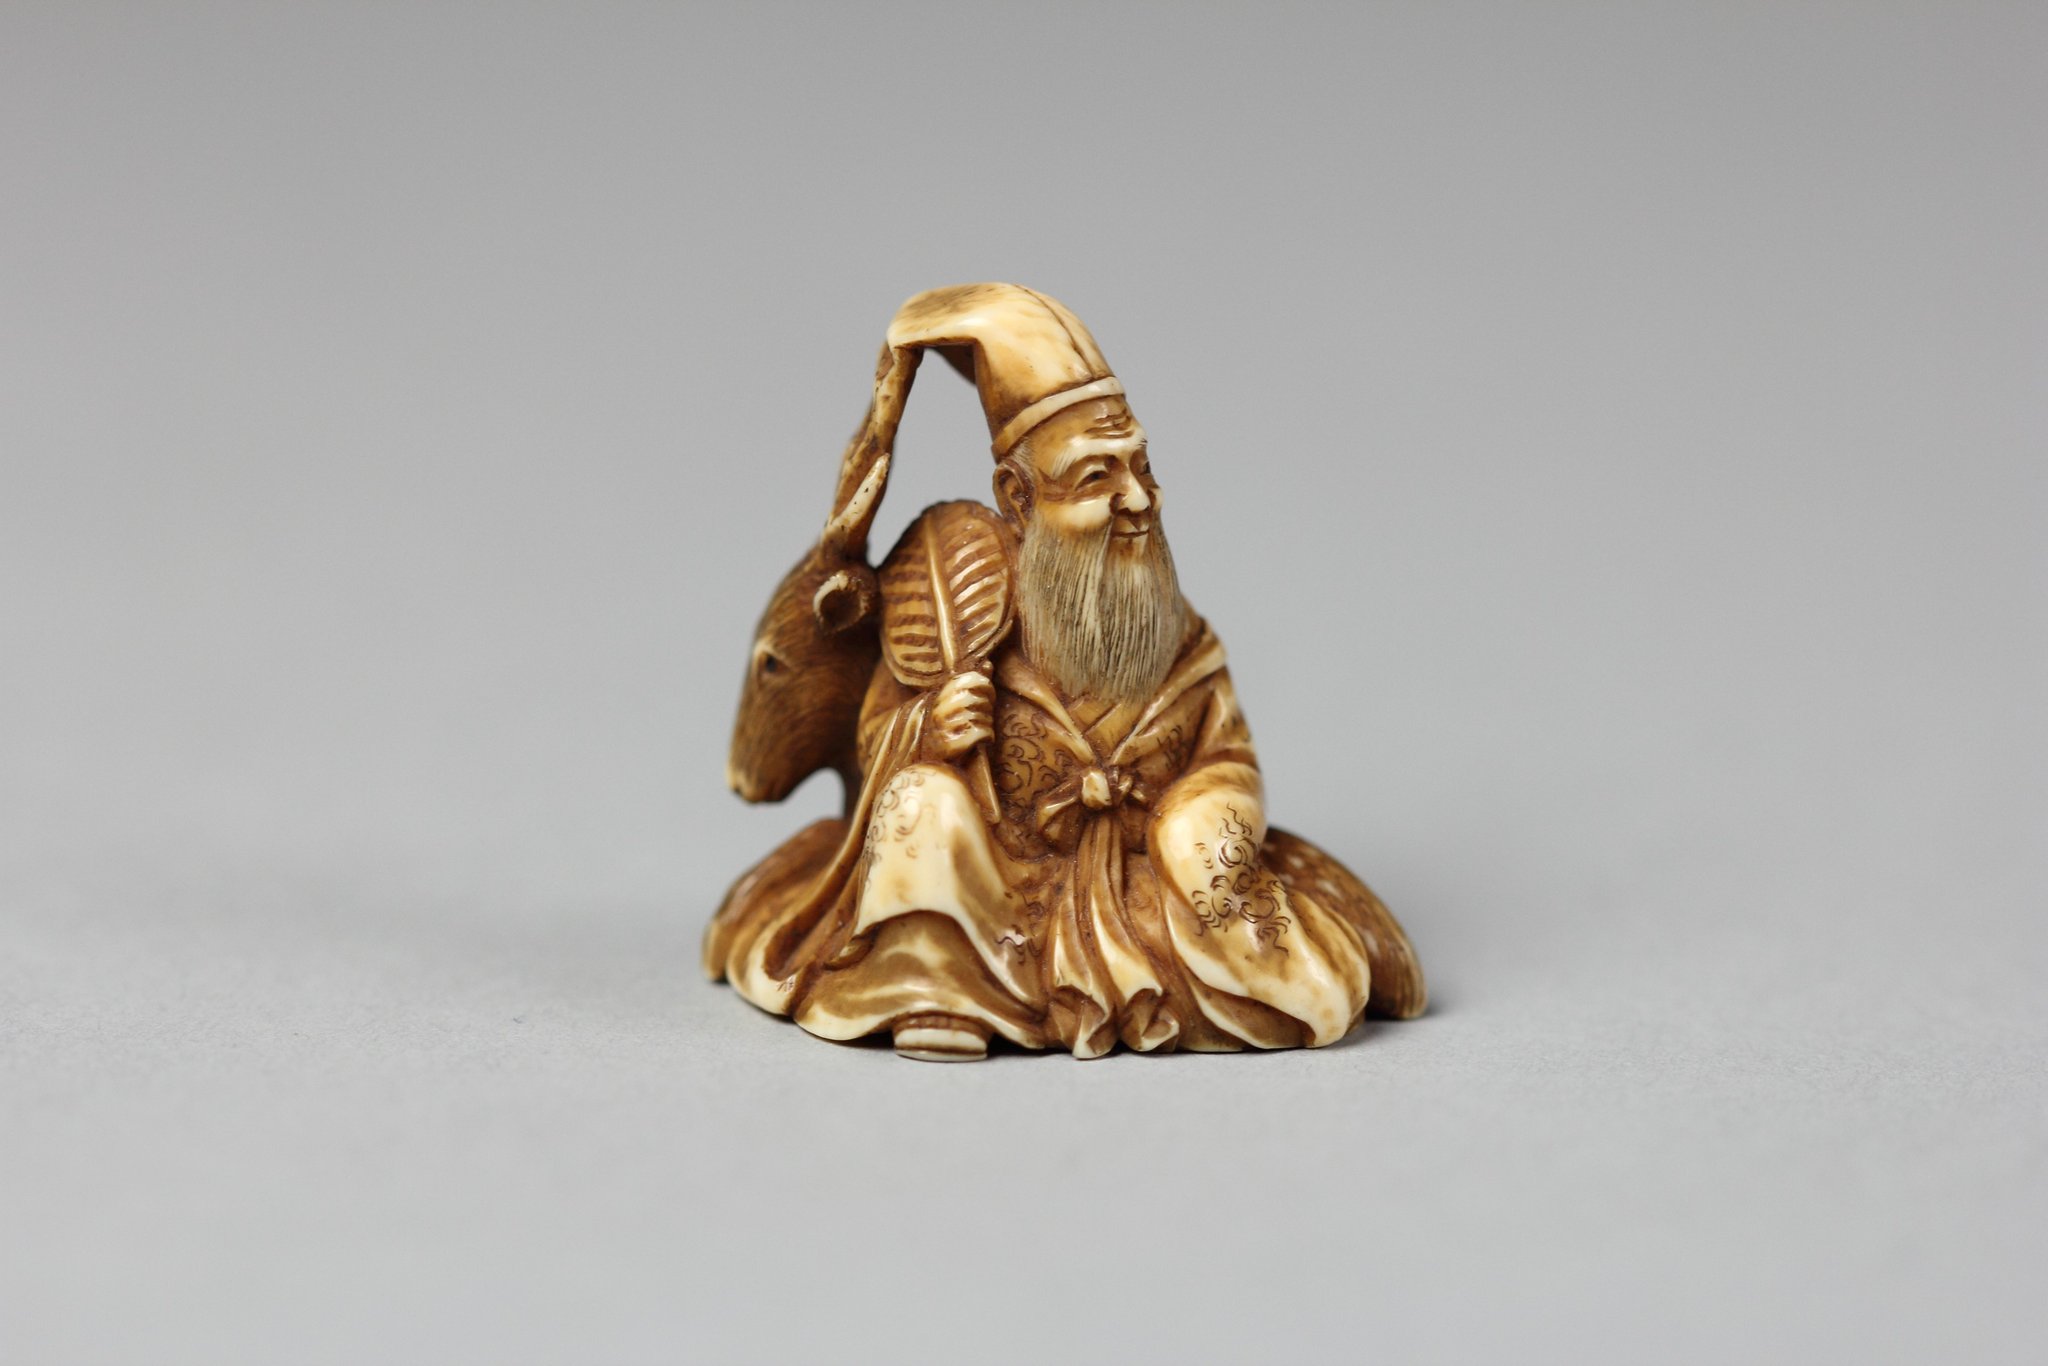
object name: netsuke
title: Netsuke of Fukurokojin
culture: japanese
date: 1801-1900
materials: ivory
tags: men